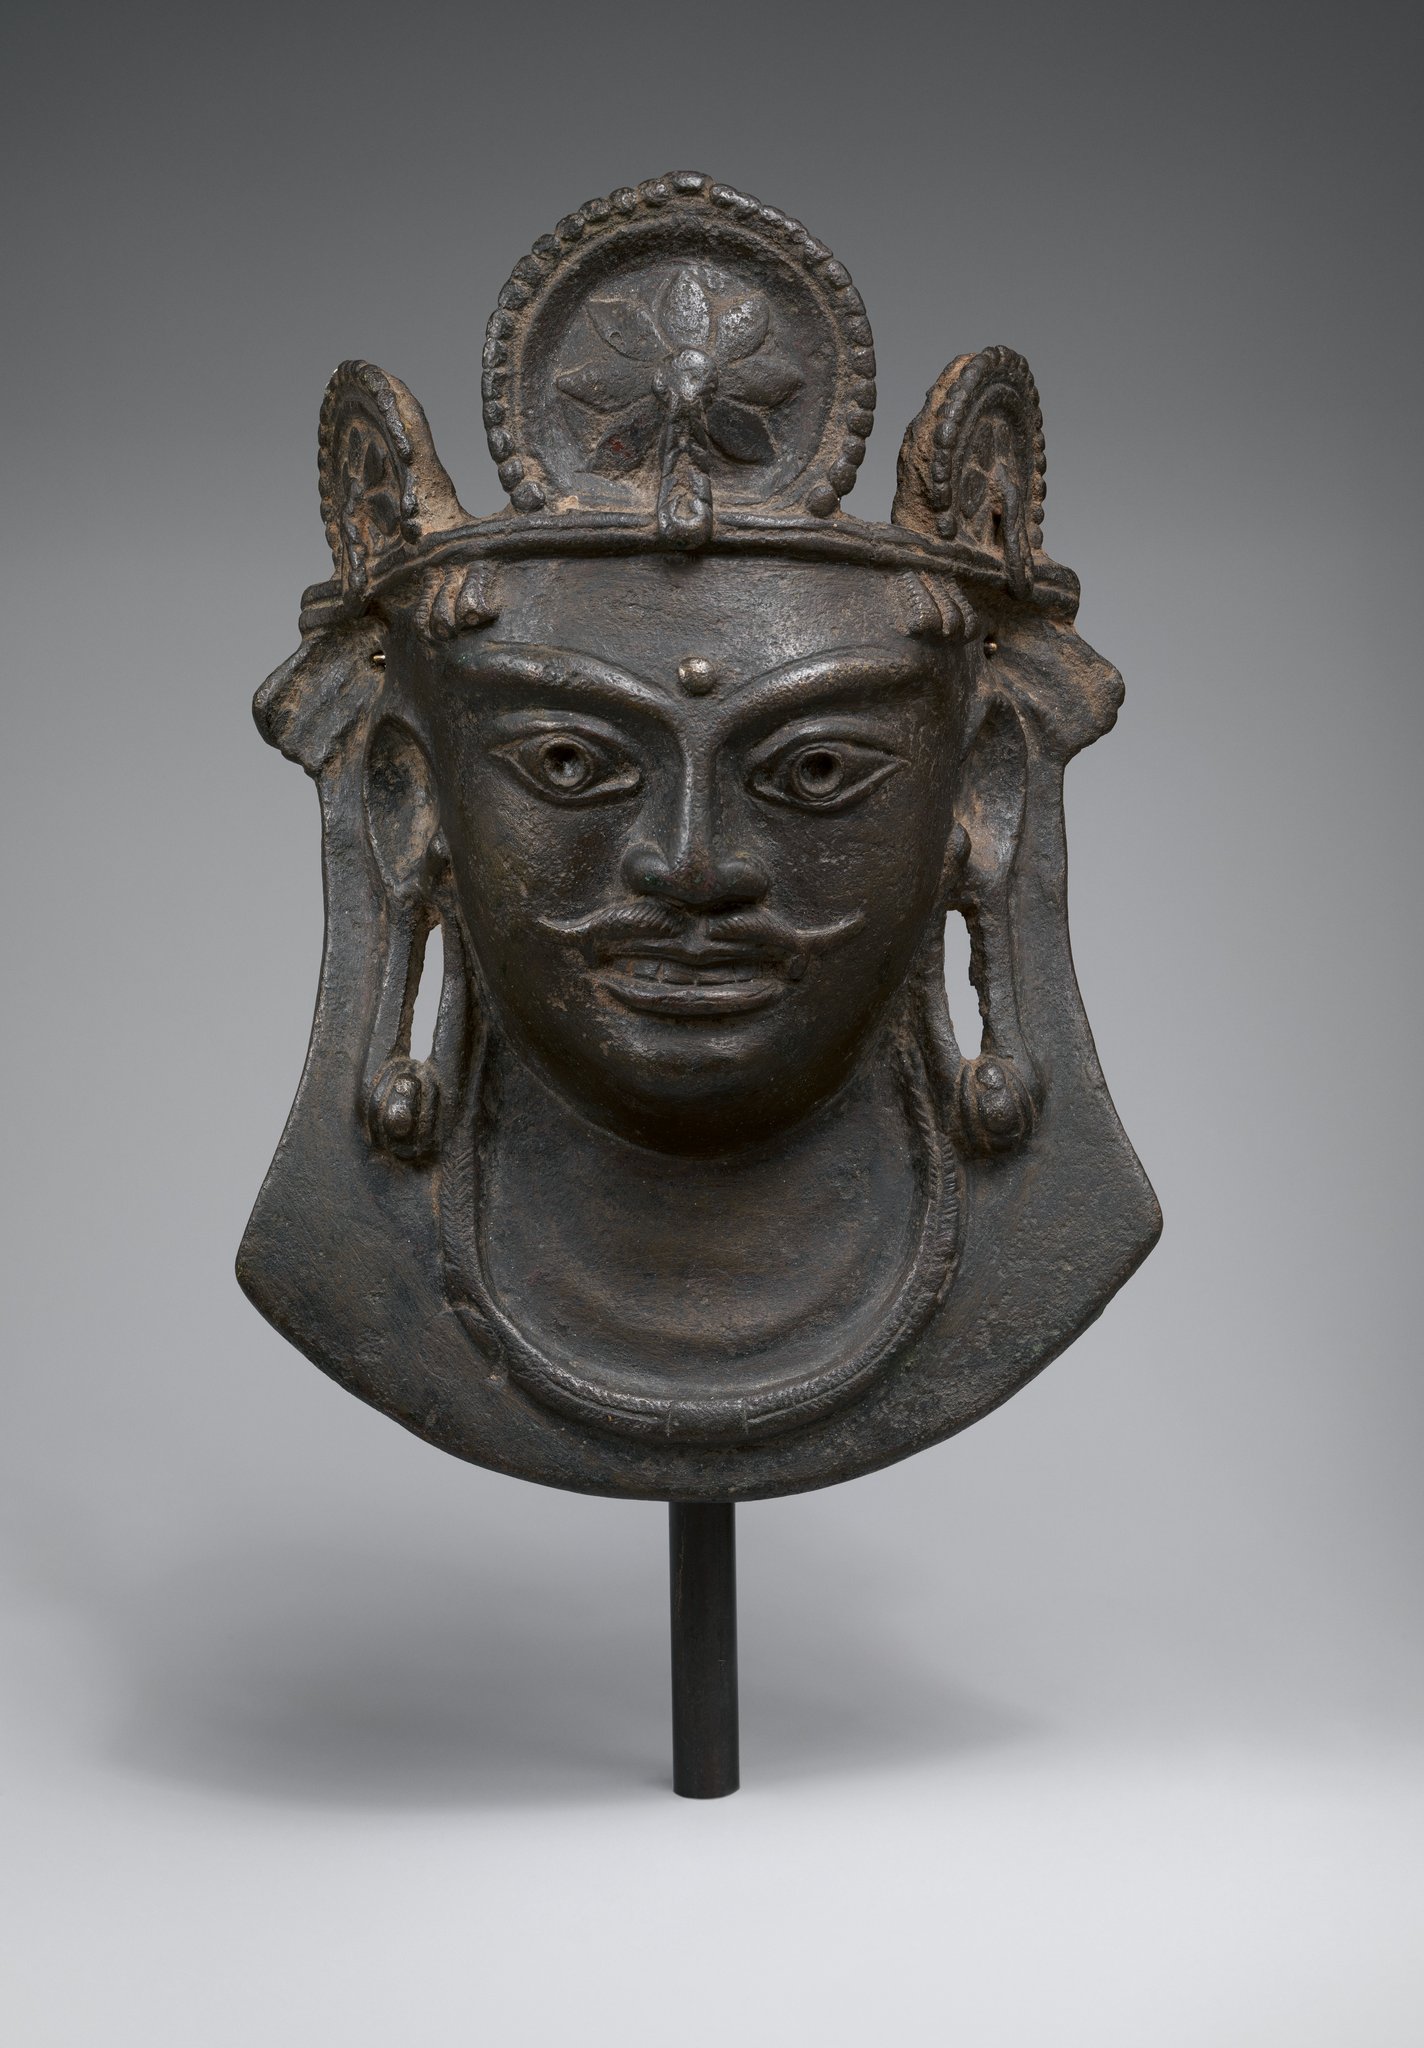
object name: mask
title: Mask of Bhairava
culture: kashmiri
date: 567-700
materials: brass, copper alloy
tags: kashmir,masks